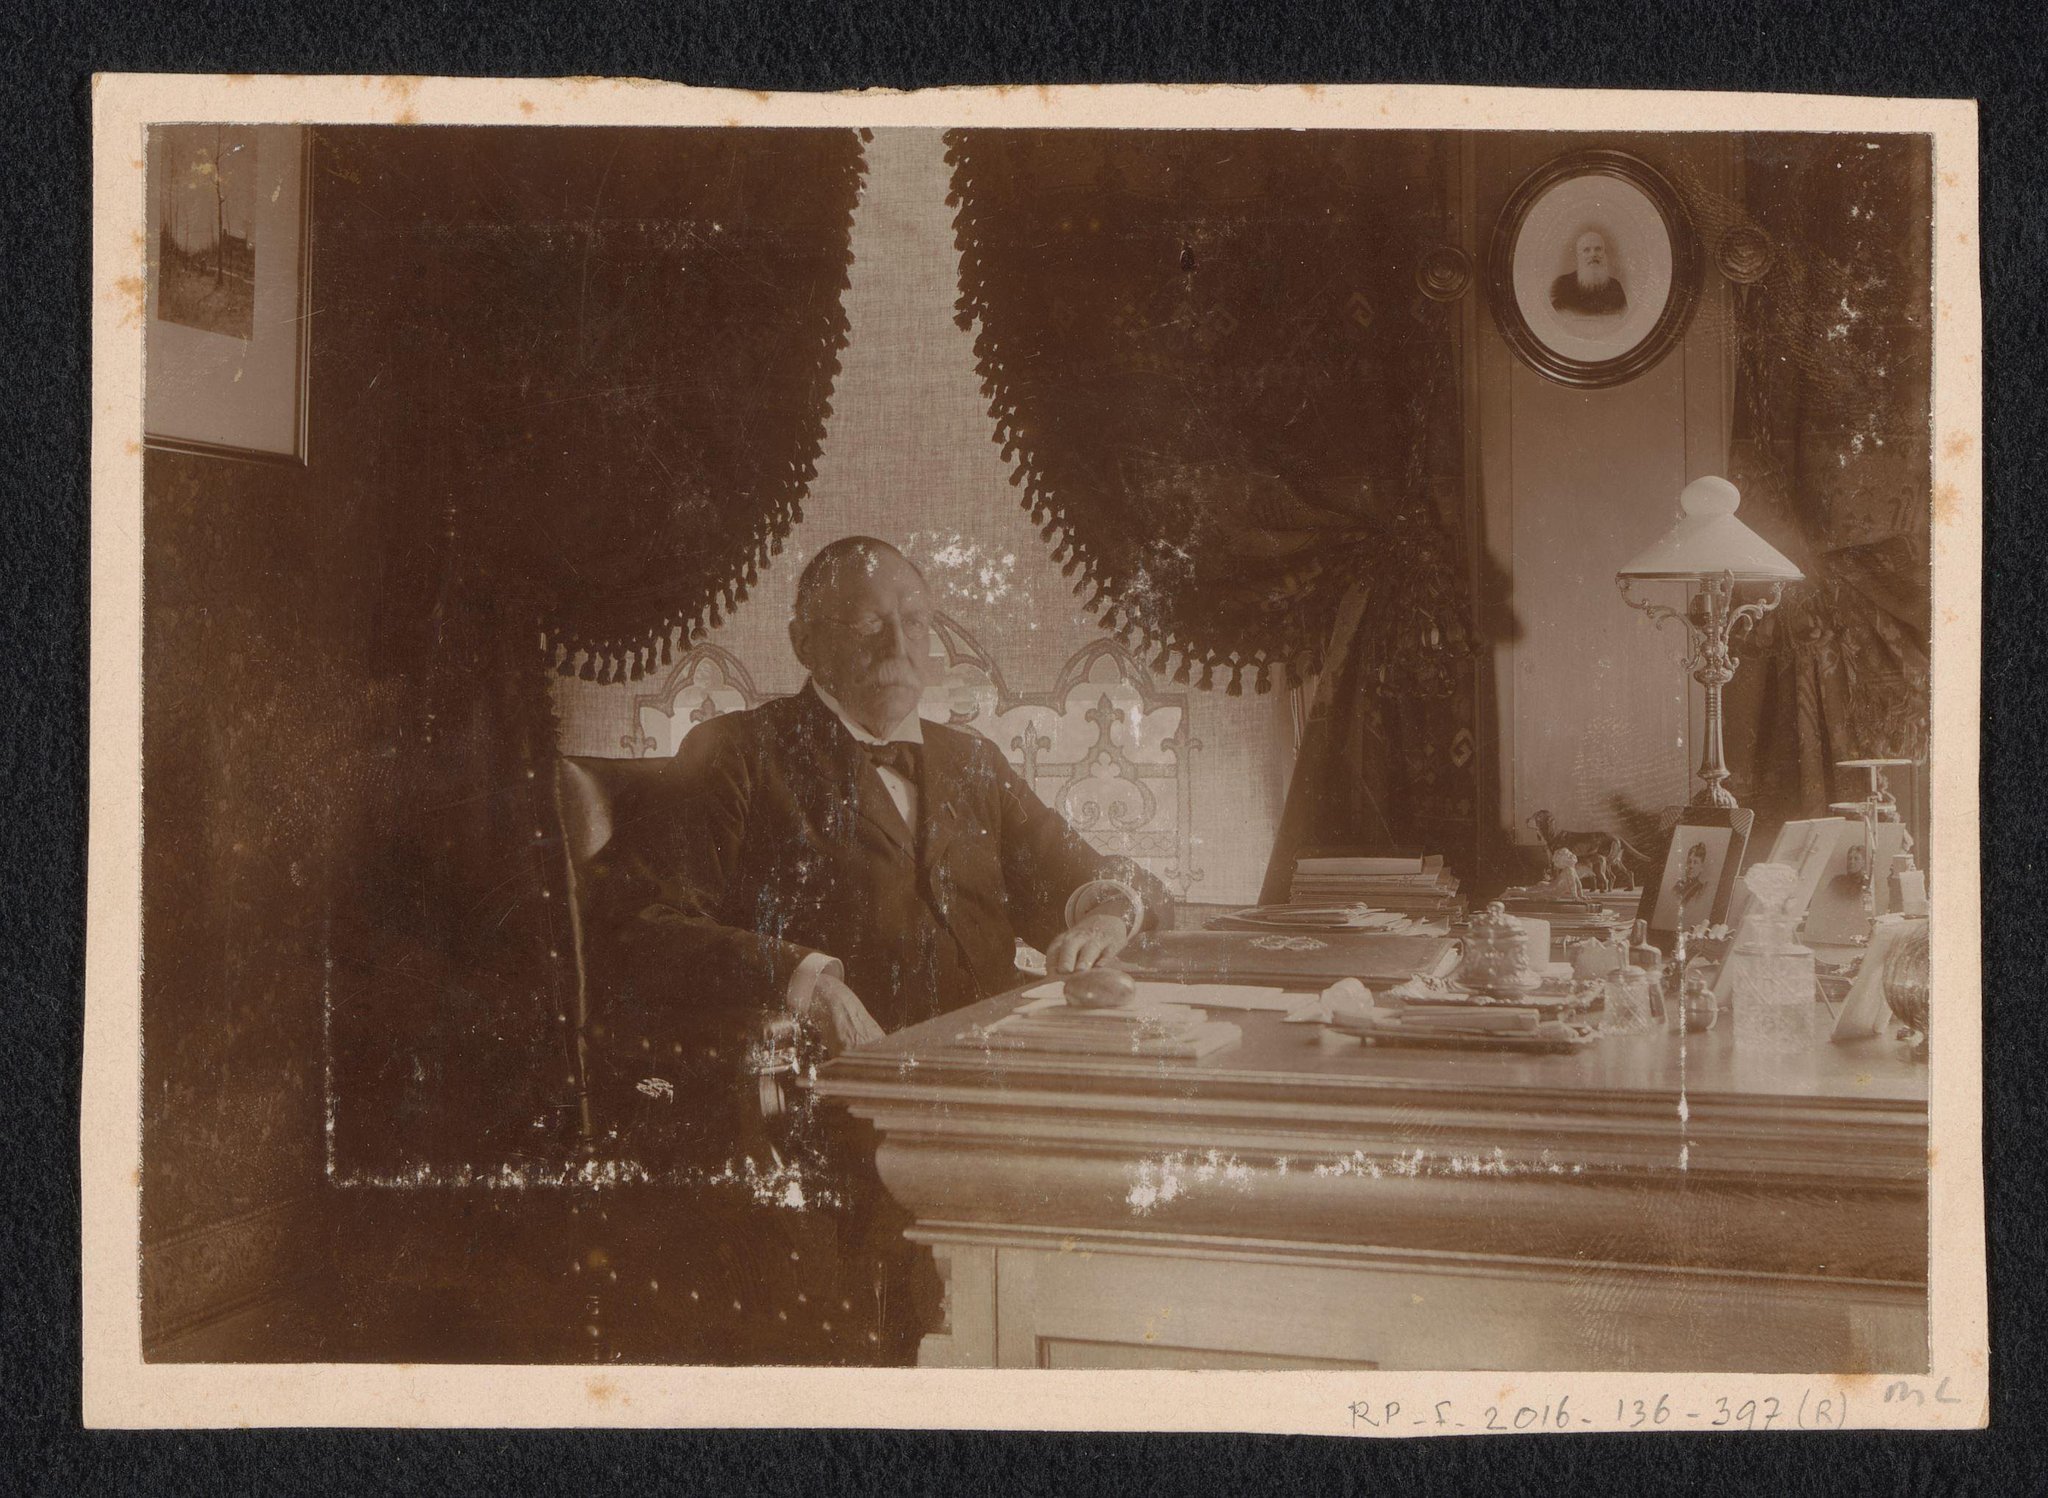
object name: photograph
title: Portret van Mr. Norbert Petrus van den Berg achter zijn bureau in zijn werkkamer op Turfmarkt 3, Amsterdam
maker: hendrik herman van den berg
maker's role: amateurfotograaf, jurist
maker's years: 1875-1944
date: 1890-1894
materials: cardboard, photographic support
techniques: collodion silver print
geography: amsterdam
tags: historical persons (portraits and scenes from the life)